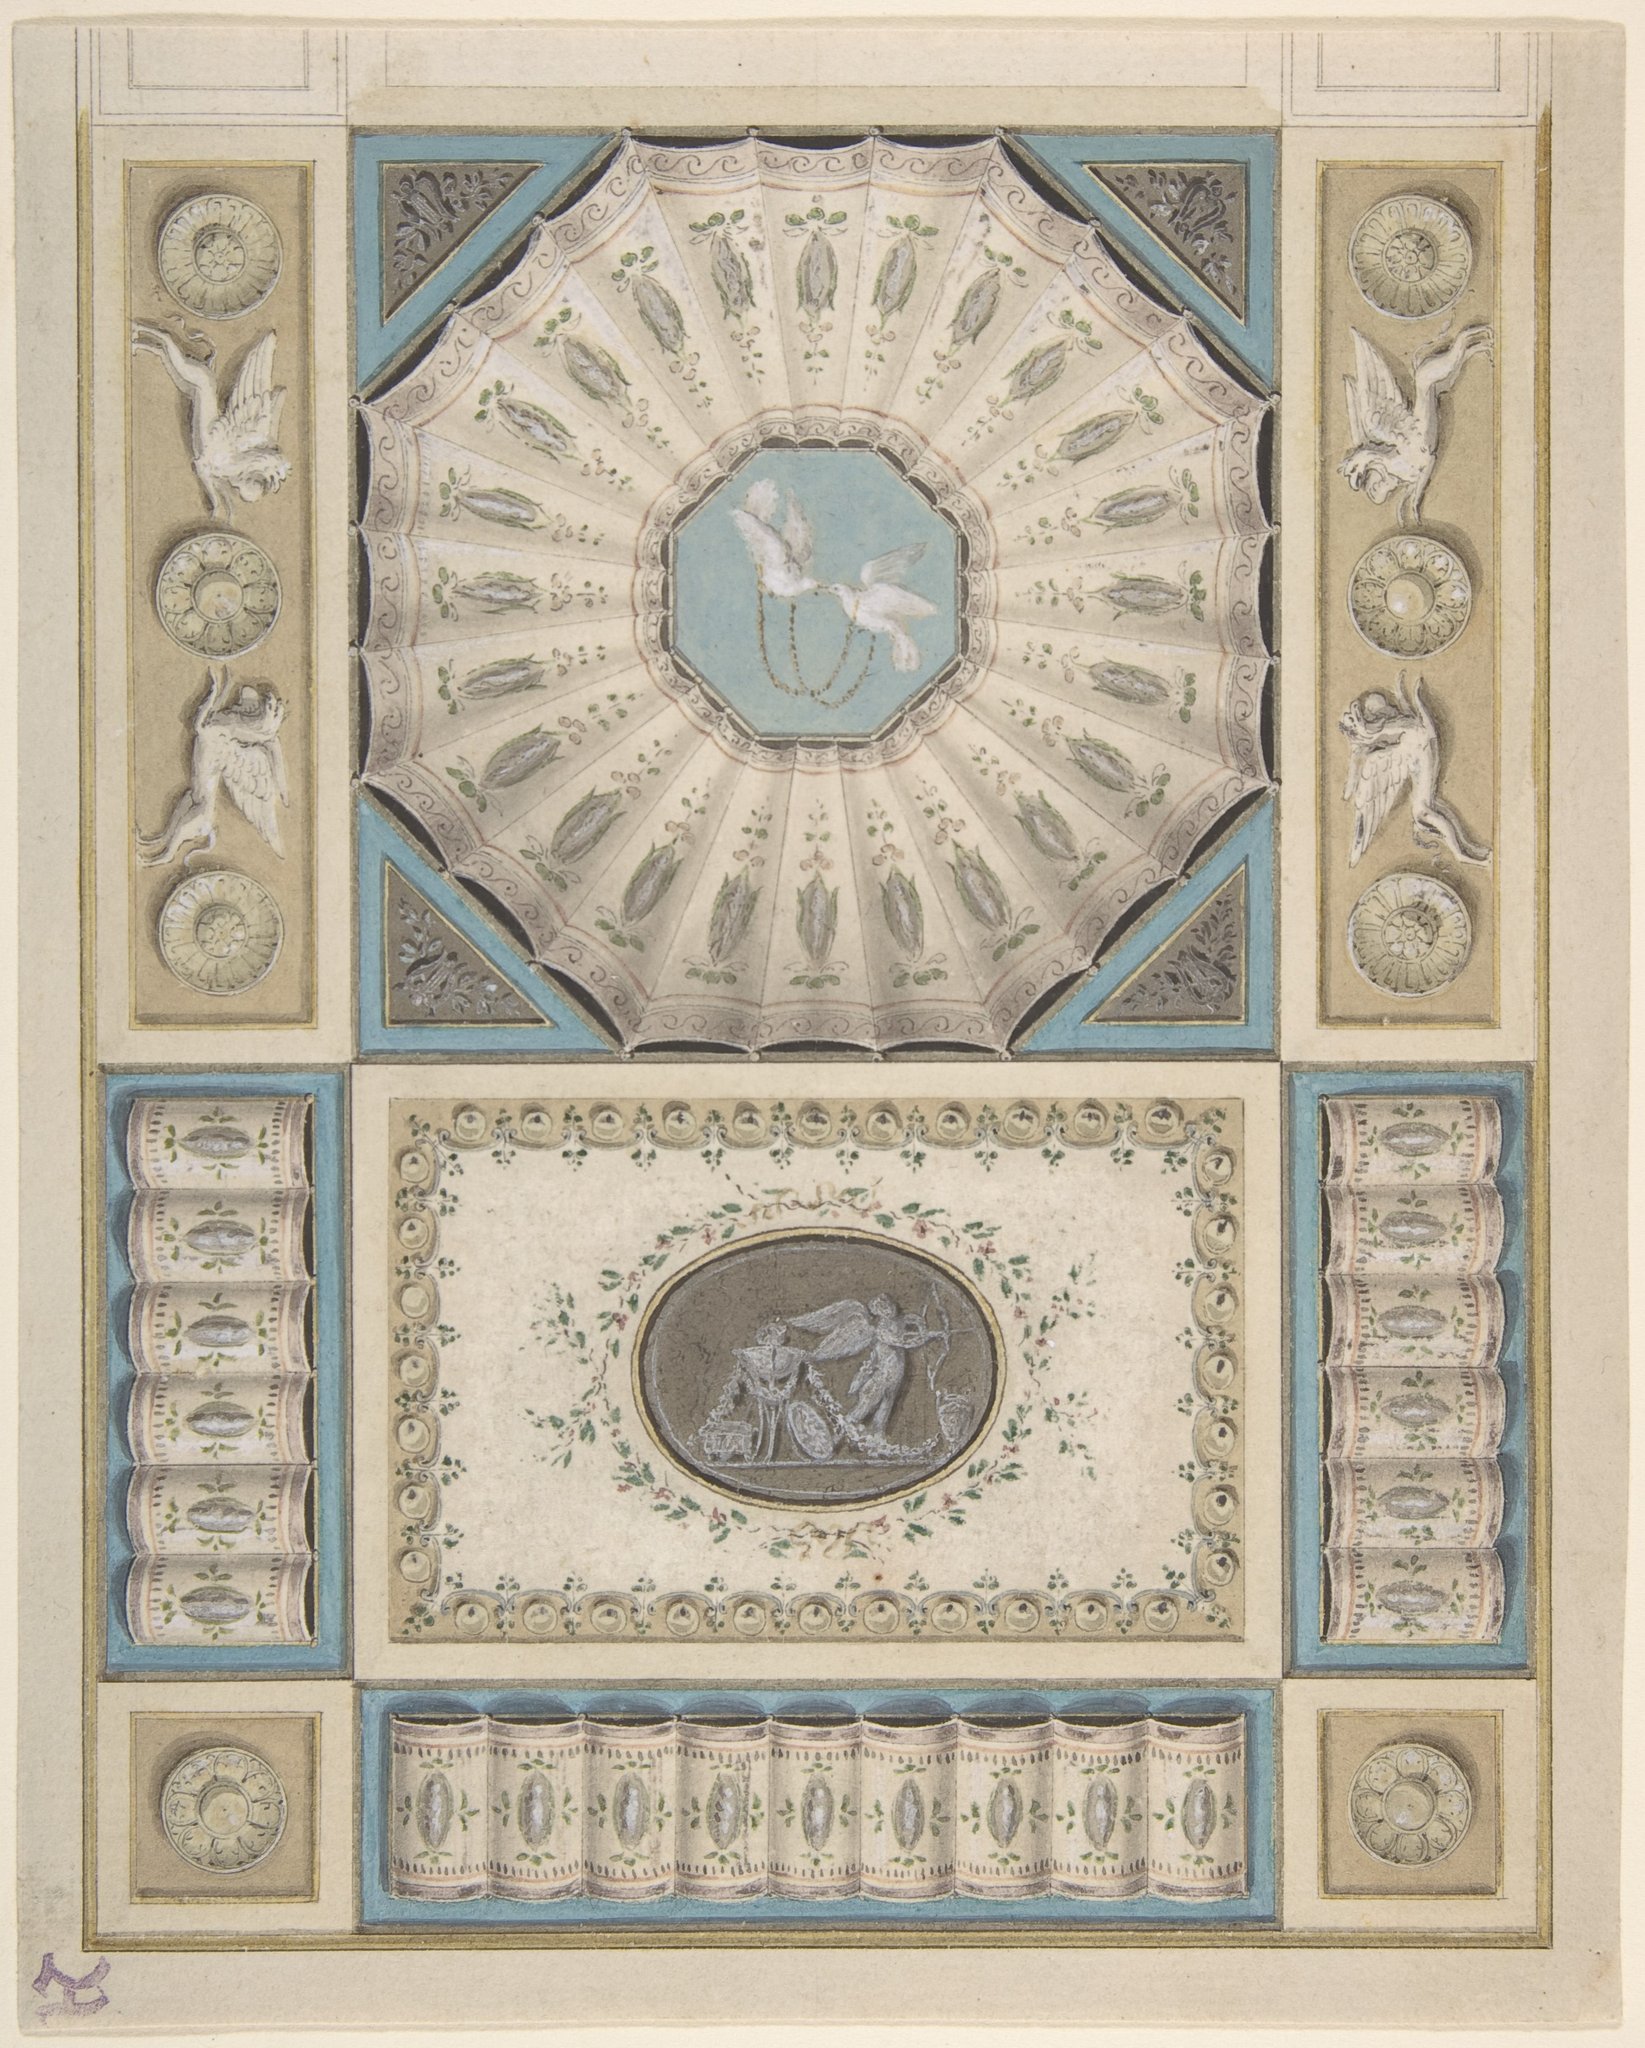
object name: drawing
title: Design for Ceiling Decoration in Neoclassical Style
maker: anonymous, italian, roman, 18th century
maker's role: artist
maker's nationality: italian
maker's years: 1700-1800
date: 1790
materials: gouache, ink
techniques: brush, highlighting, pen, wash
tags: birds,cupid,pegasus